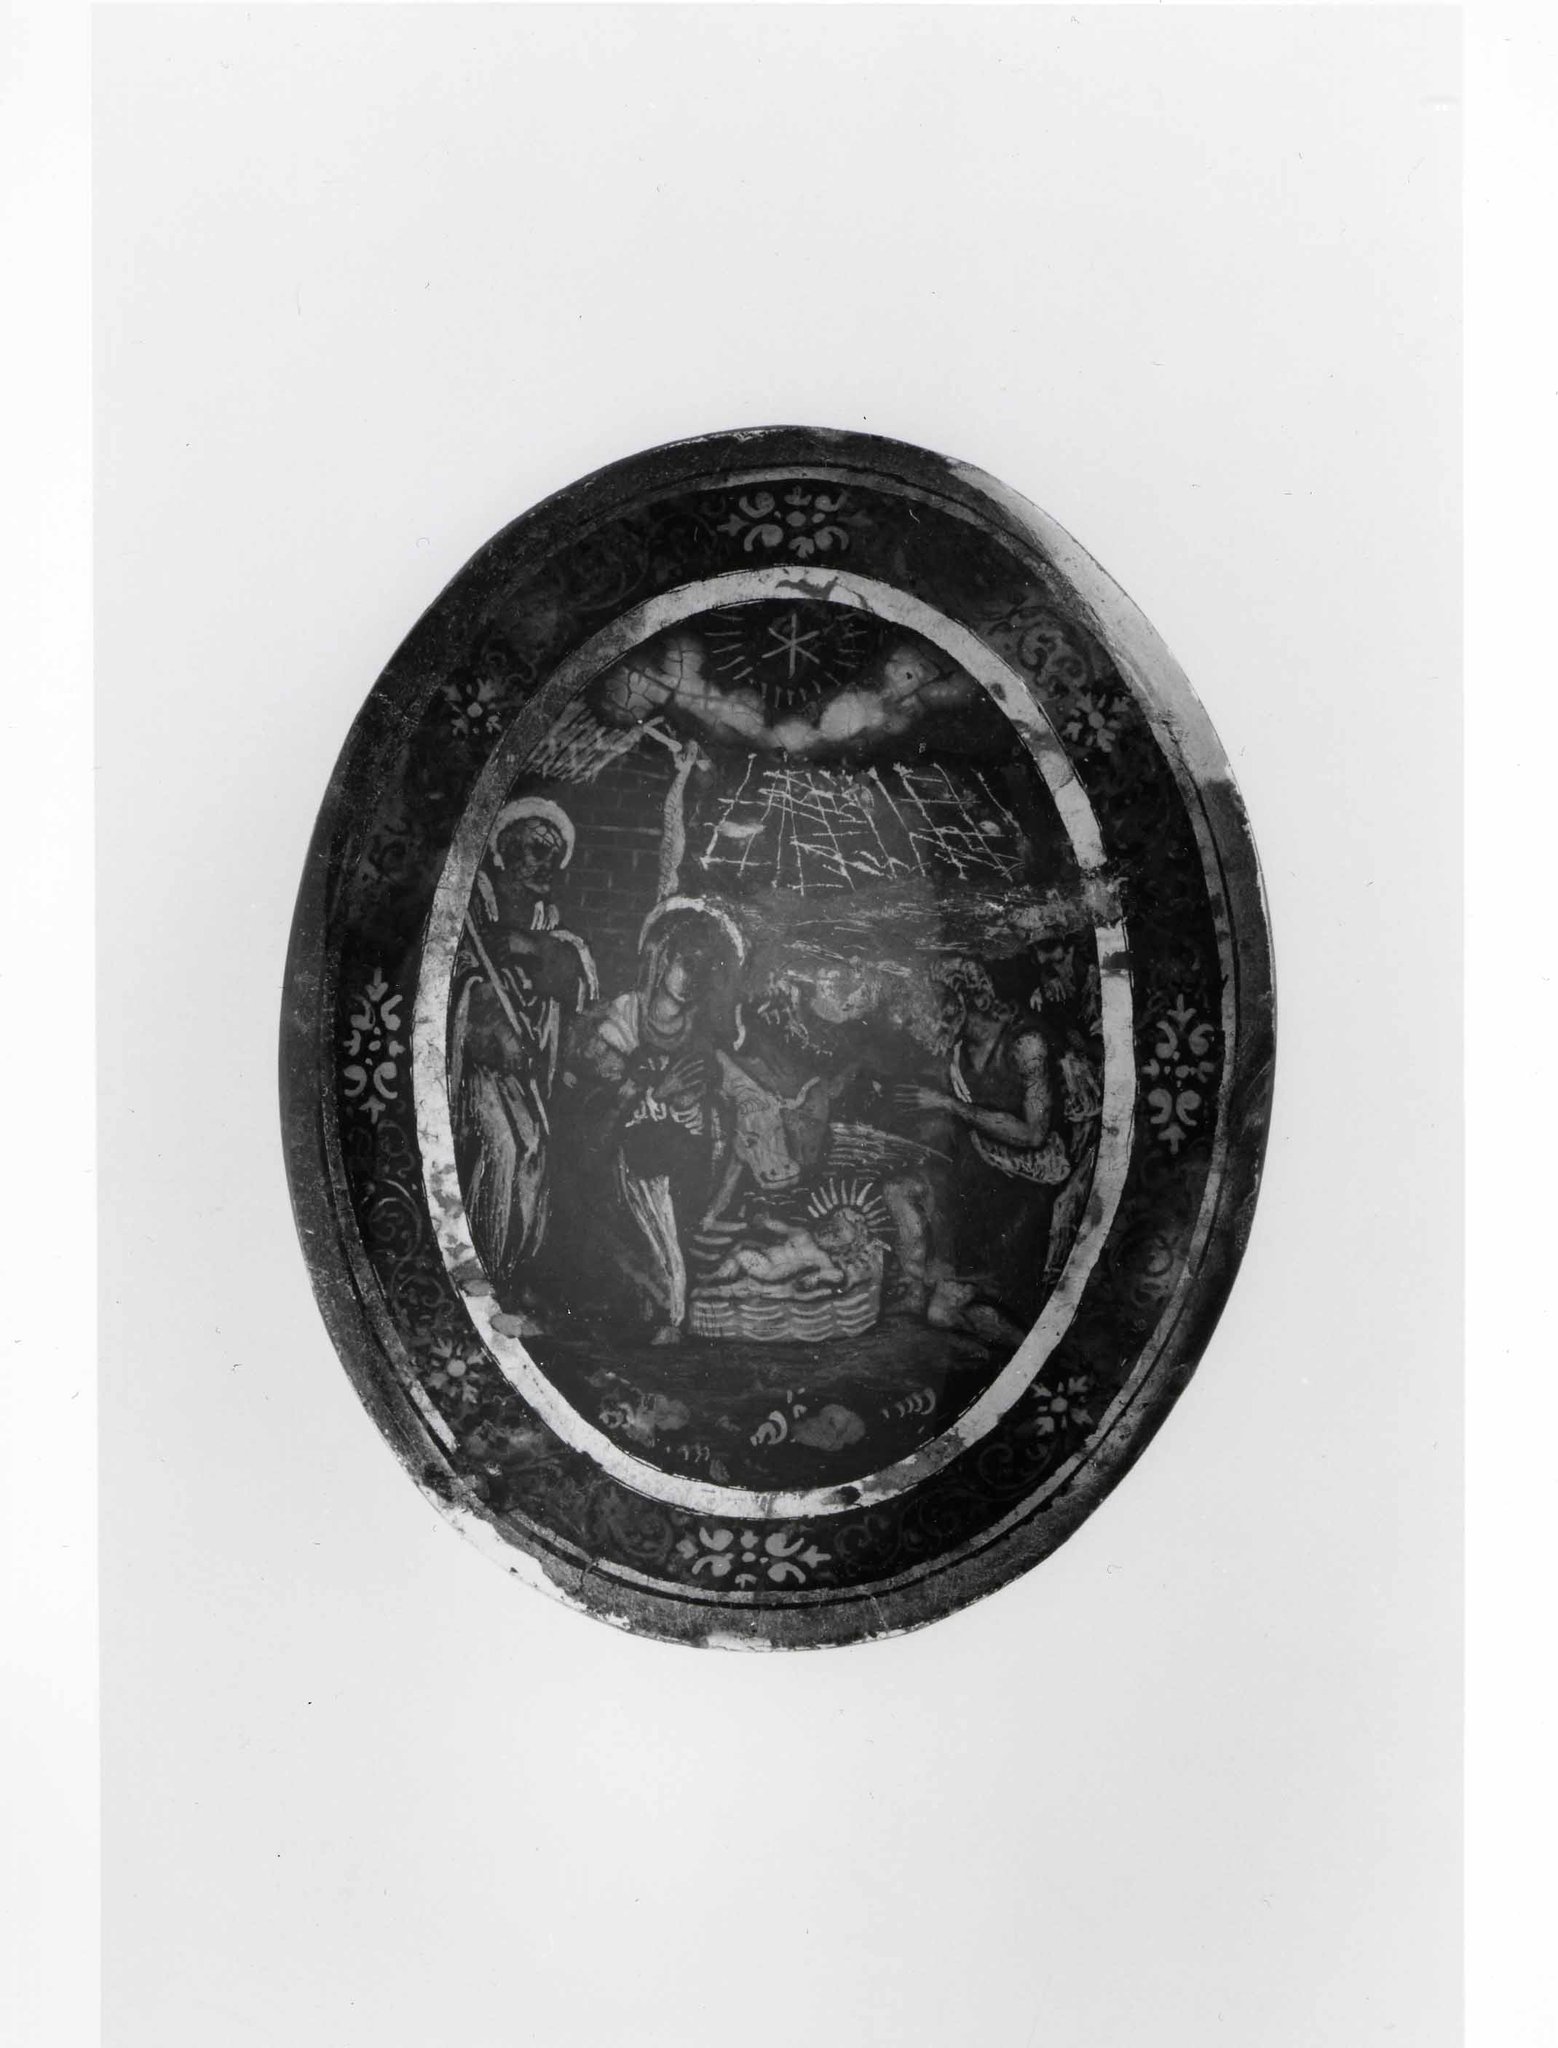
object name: plaque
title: Adoration of the Shepherds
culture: italian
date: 1567-1600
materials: gilt, quartz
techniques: cutting, painting, polish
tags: adoration of the shepherds